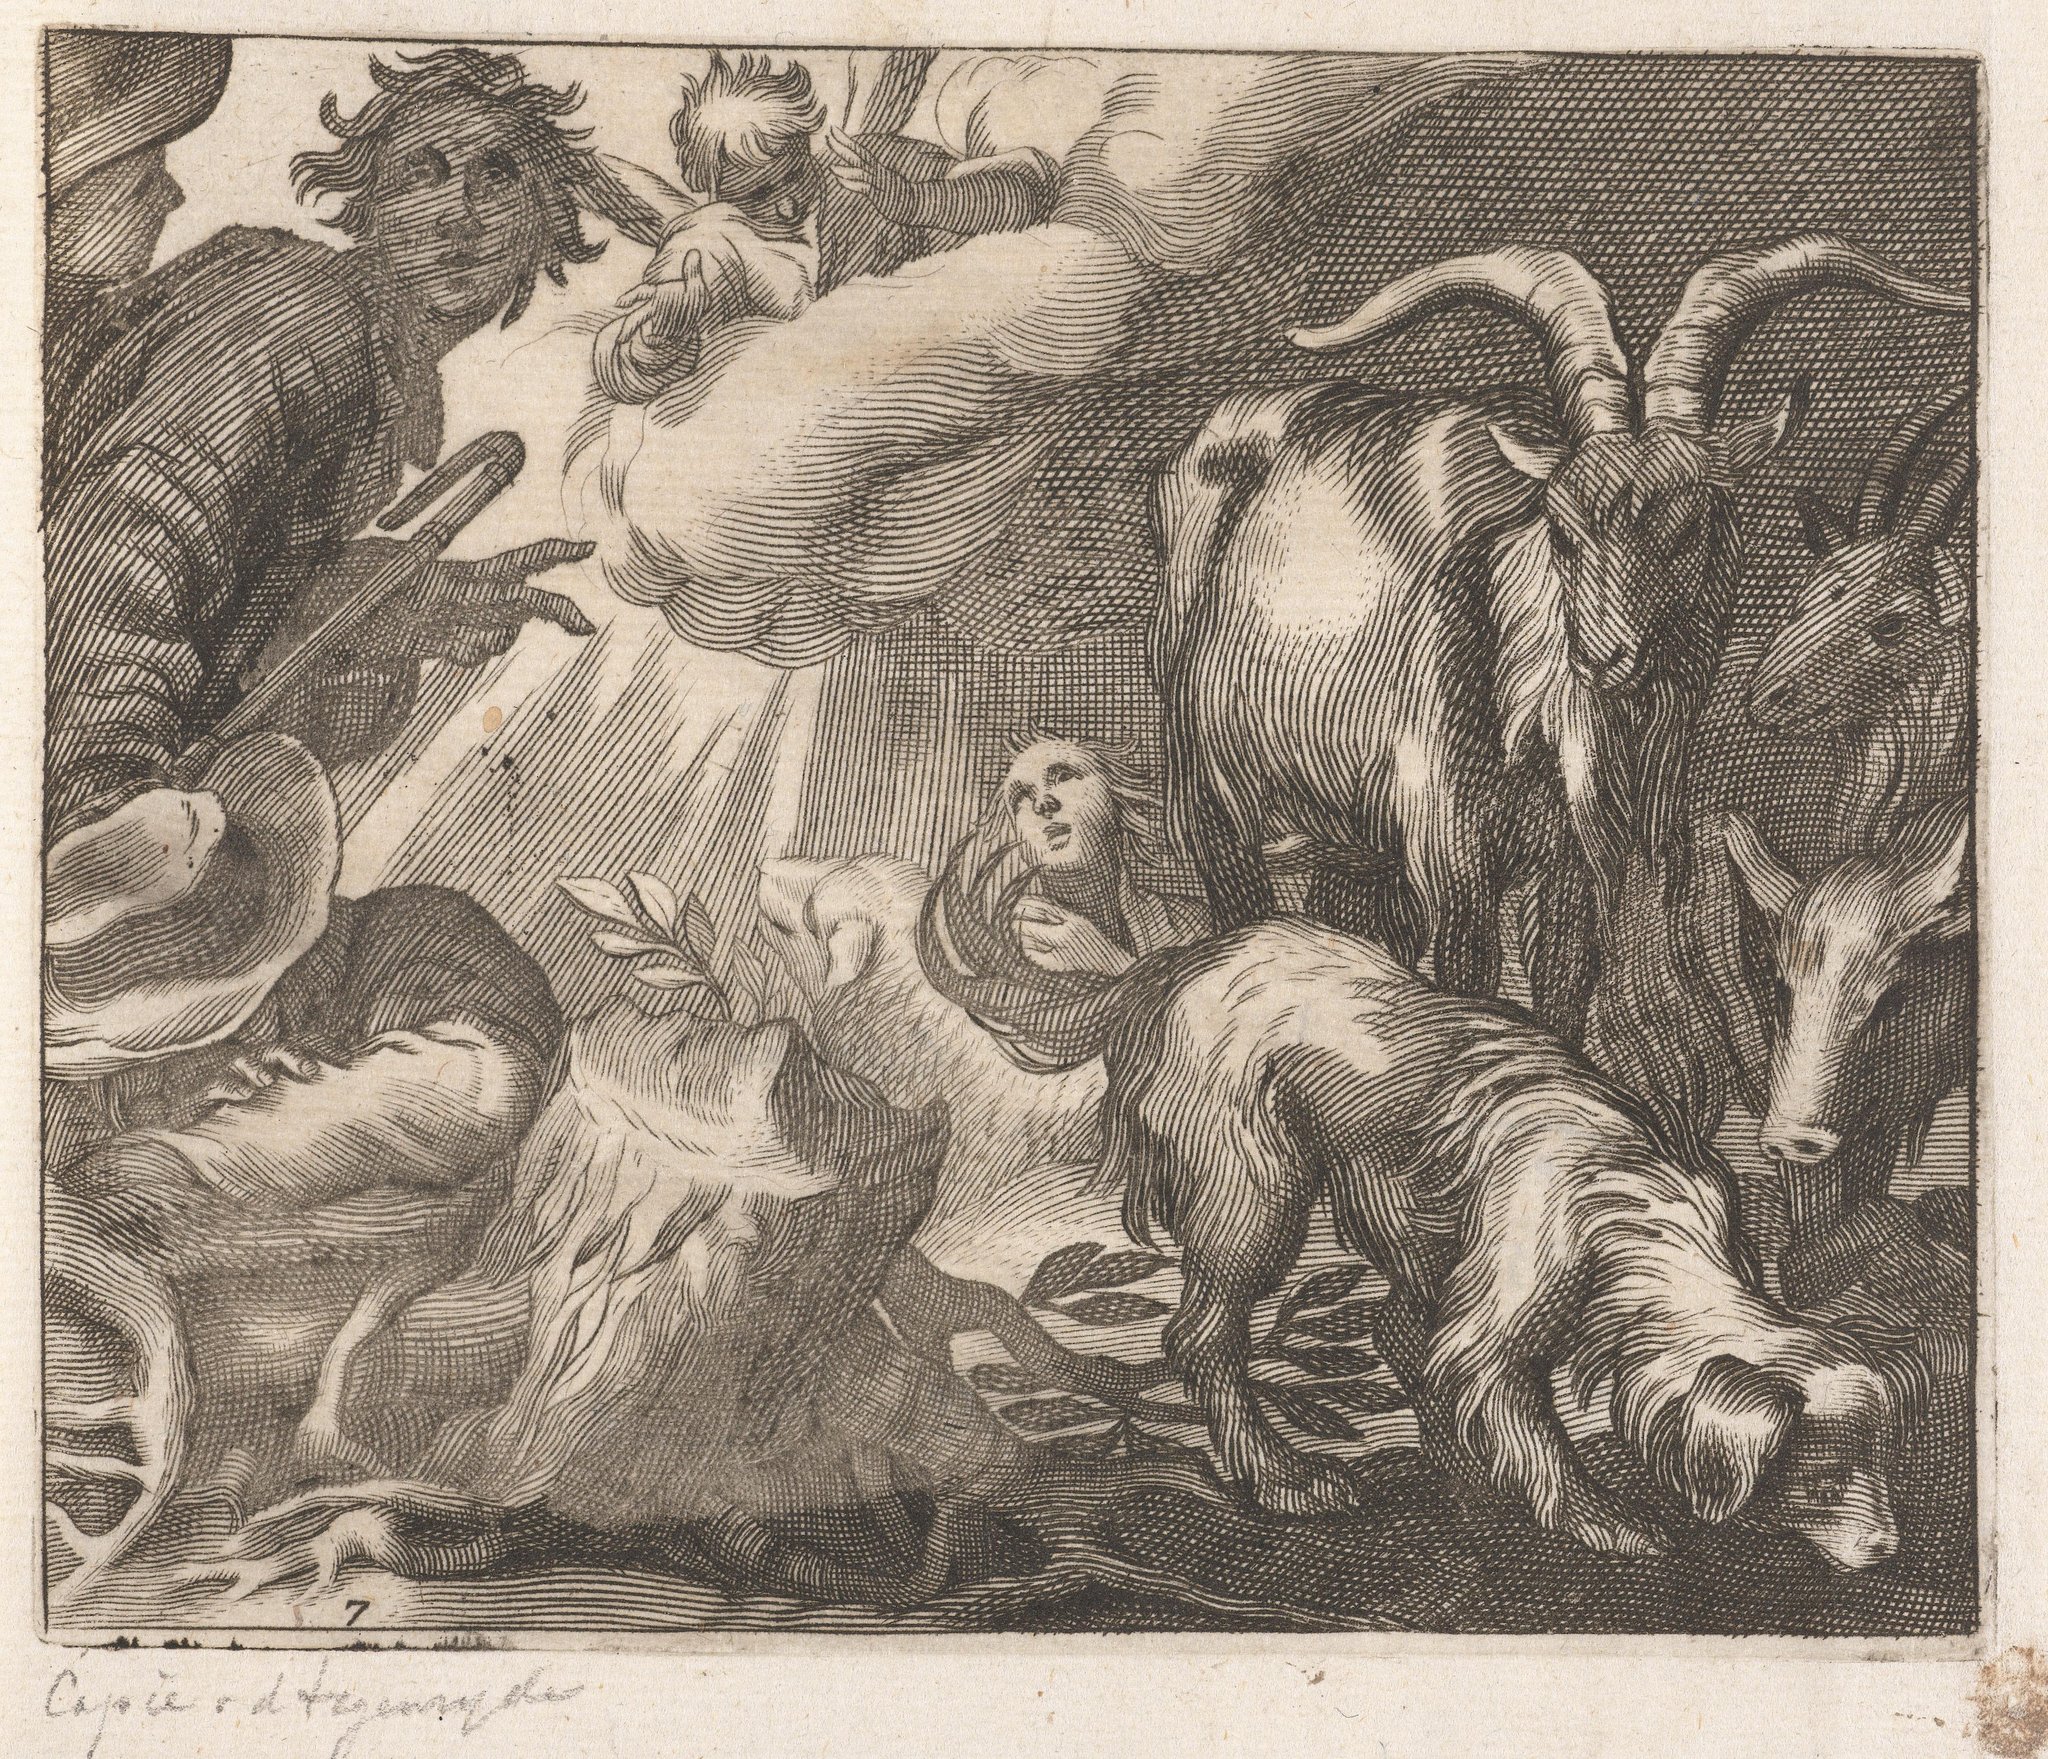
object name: print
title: Pastoralen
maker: Anonymous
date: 1611-1661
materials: paper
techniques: engraving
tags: annunciation of christ's birth to the shepherds (and/or shepherdesses) at night; a host of singing angels in the air, dog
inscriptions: collector's mark: Lugt 2228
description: Kopie in spiegelbeeld naar prent uit serie met veertien prenten zogenaamde Pastoralen van B.A. Bolswert naar ontwerp van Abraham Bloemaert.